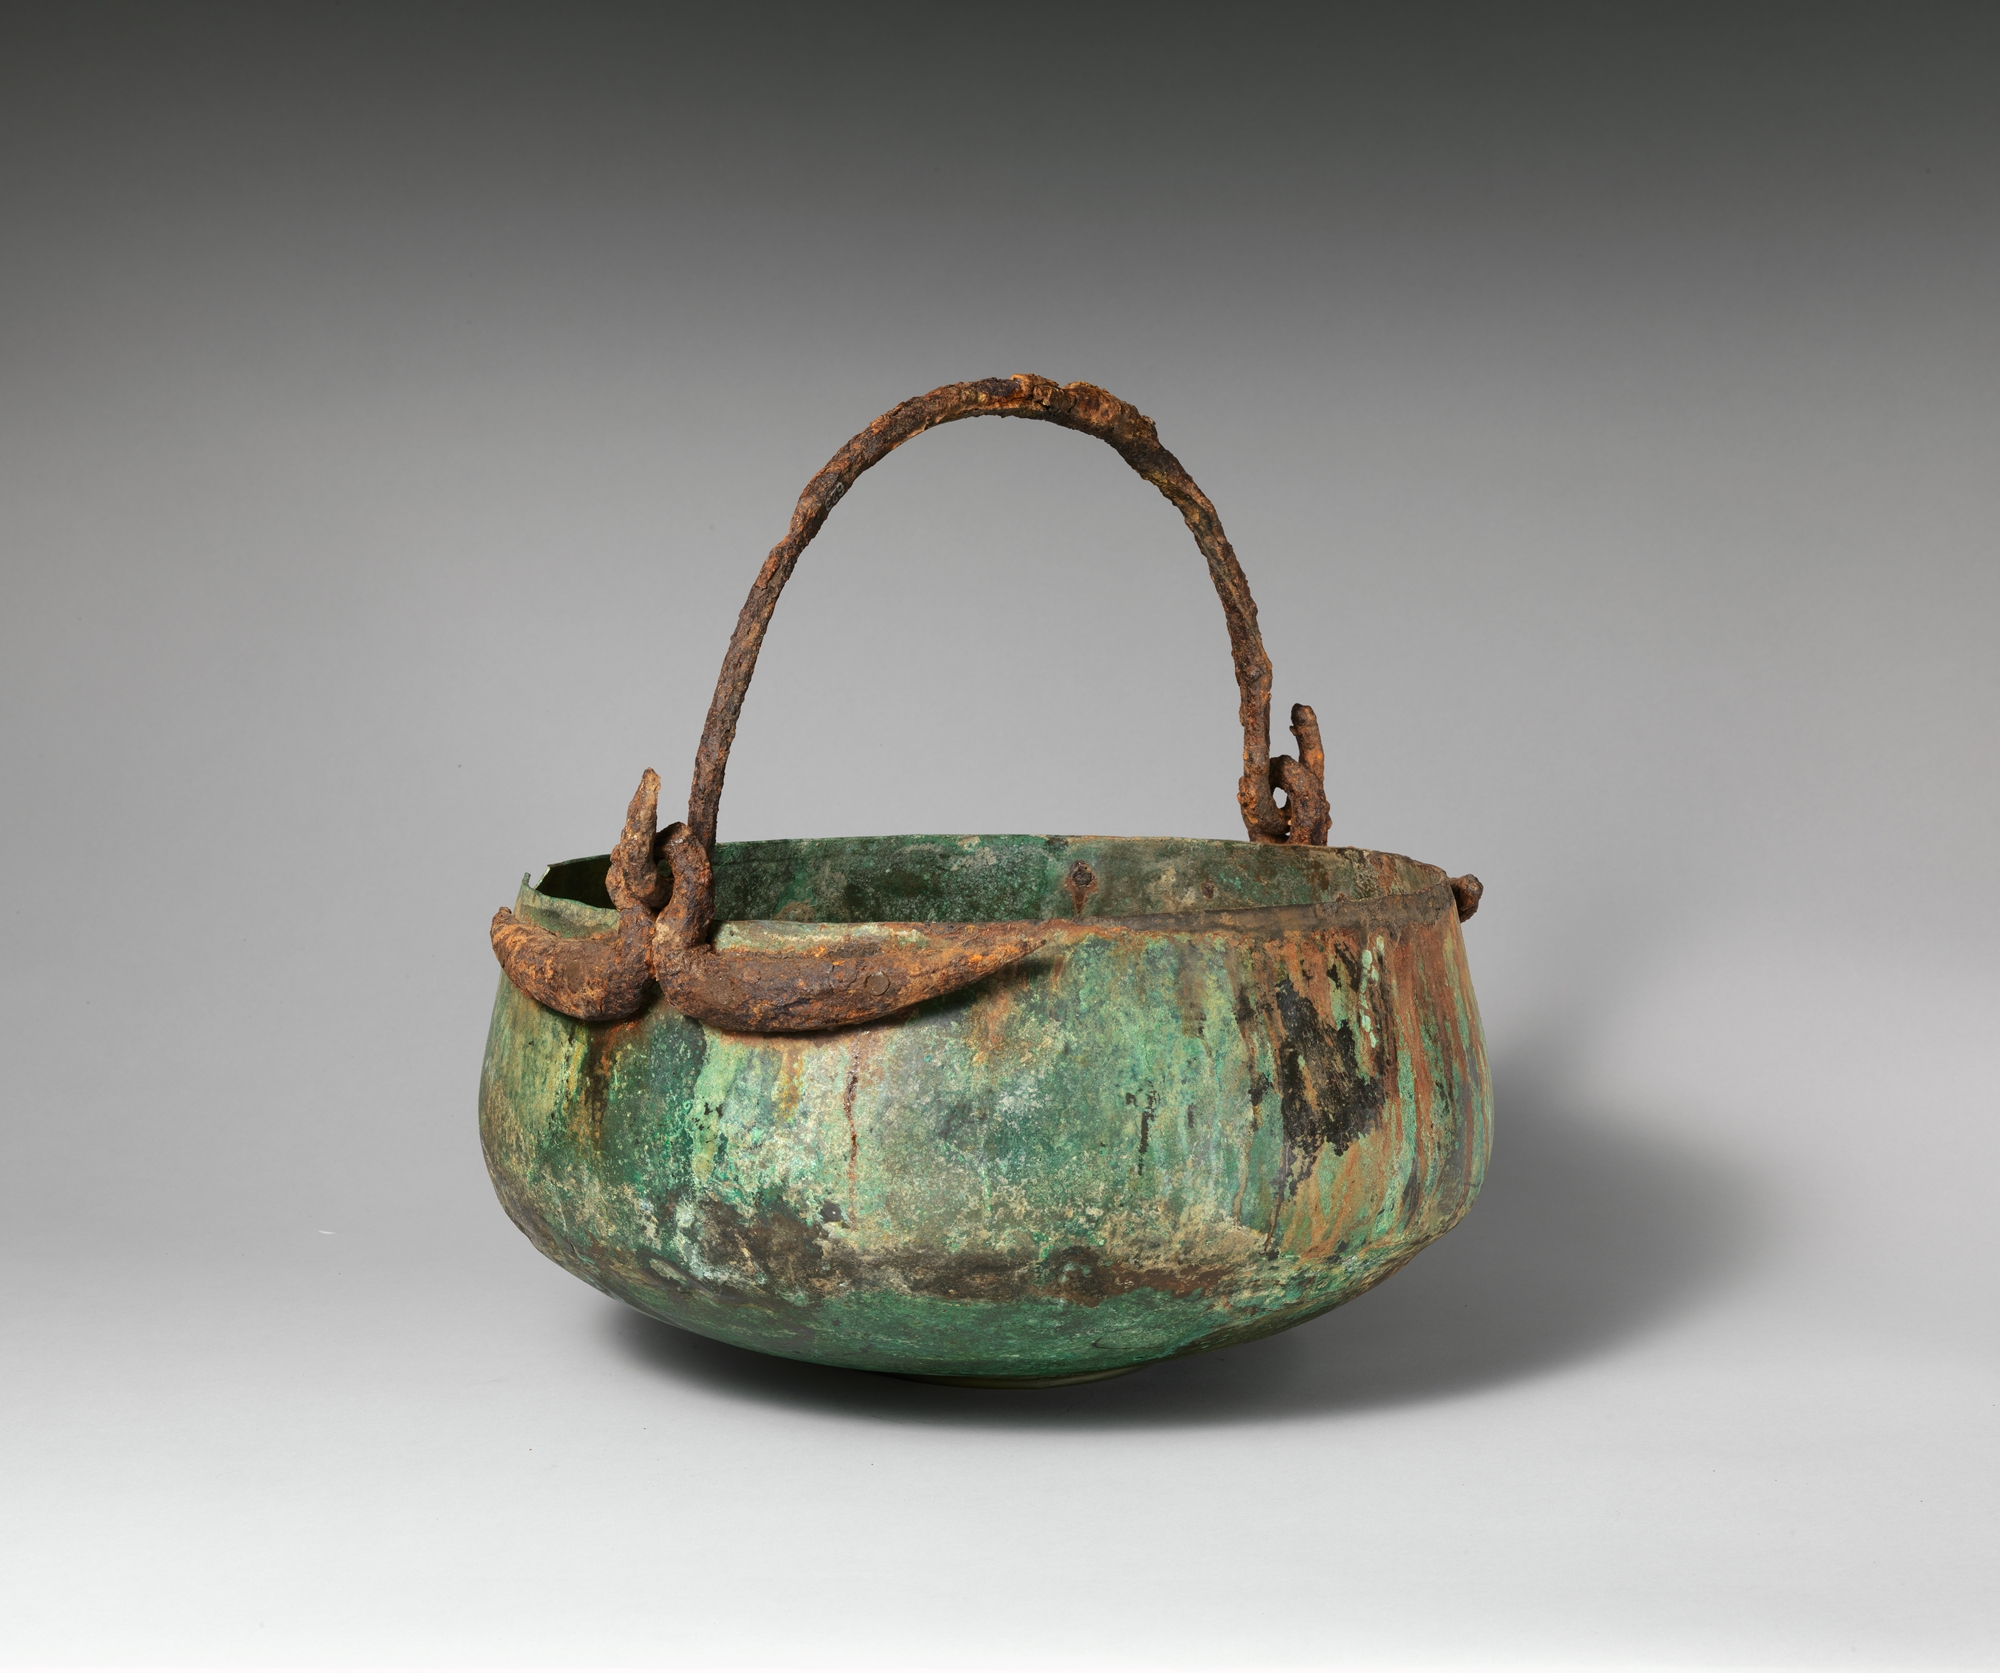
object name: cauldron with swinging handle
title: Bronze cauldron with swinging handle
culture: etruscan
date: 550 BCE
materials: bronze